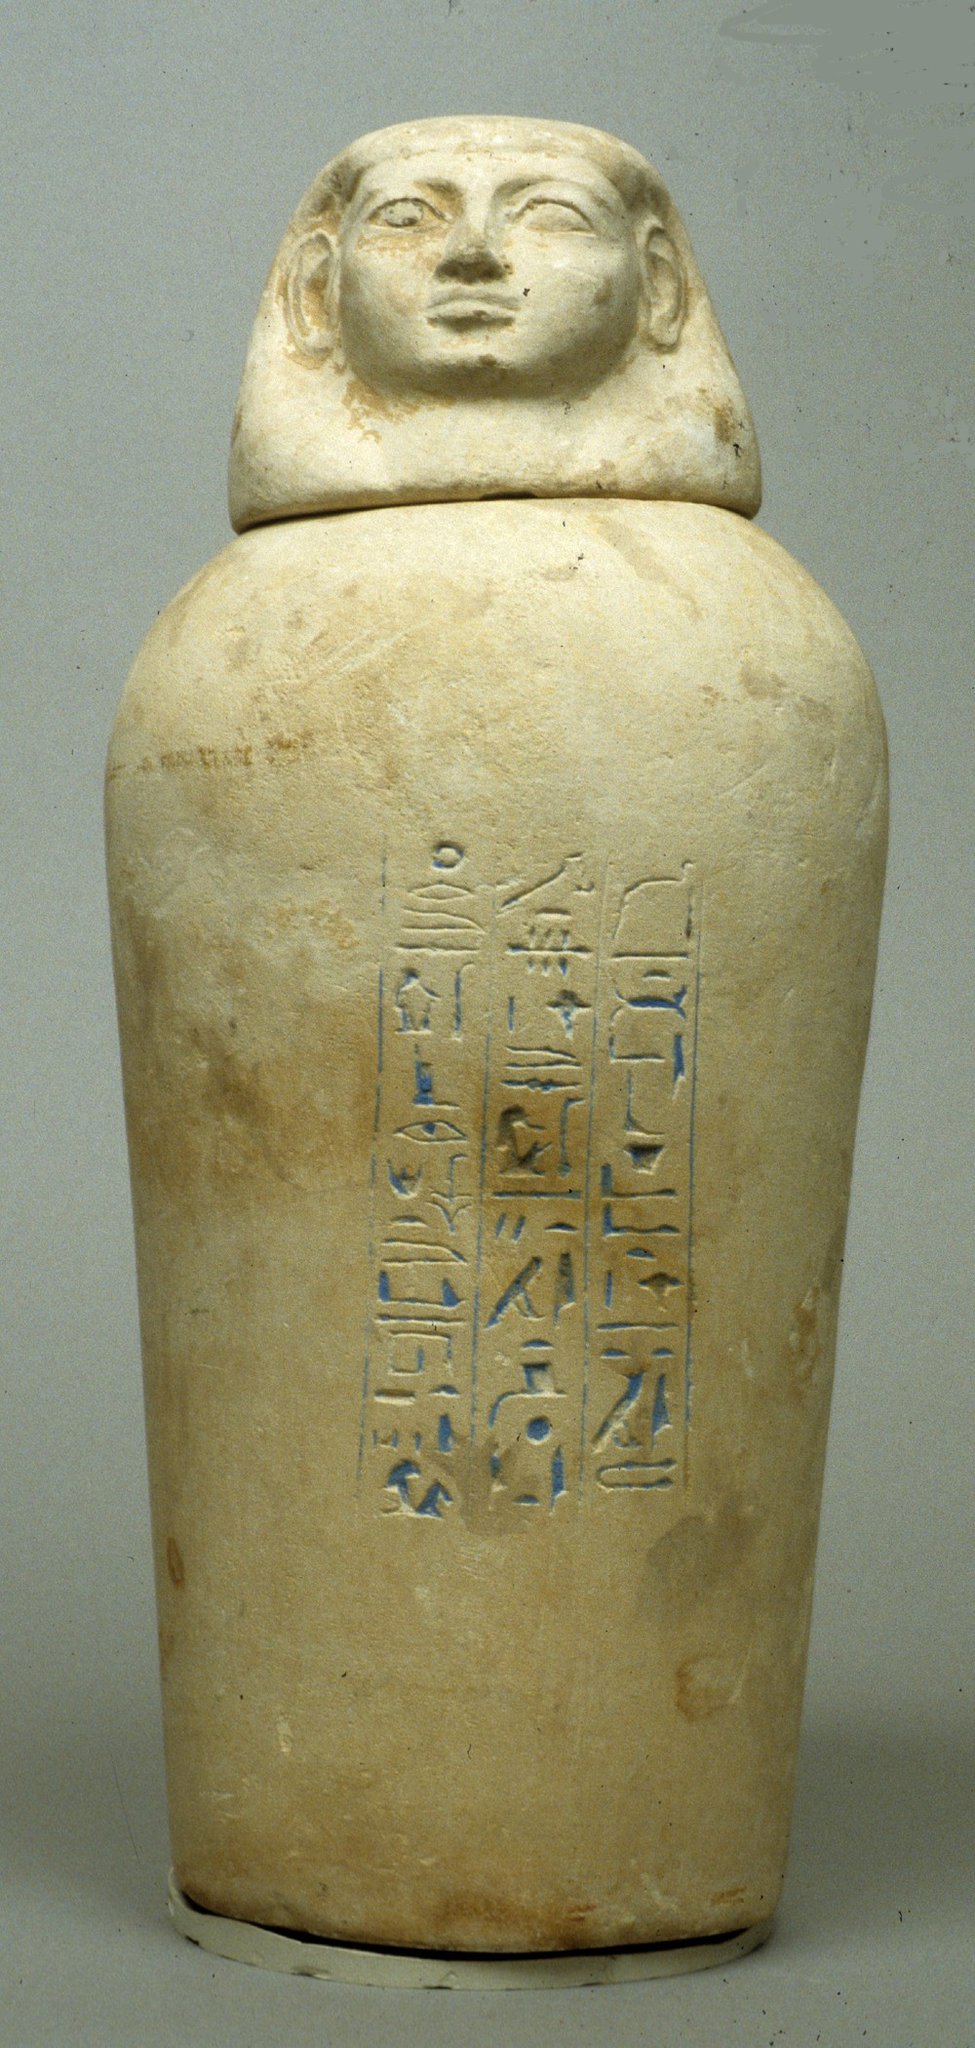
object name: canopic jar, manhata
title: Canopic Jar of Manhata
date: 1479-1425 BCE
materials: limestone, paste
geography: egypt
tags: hieroglyphs